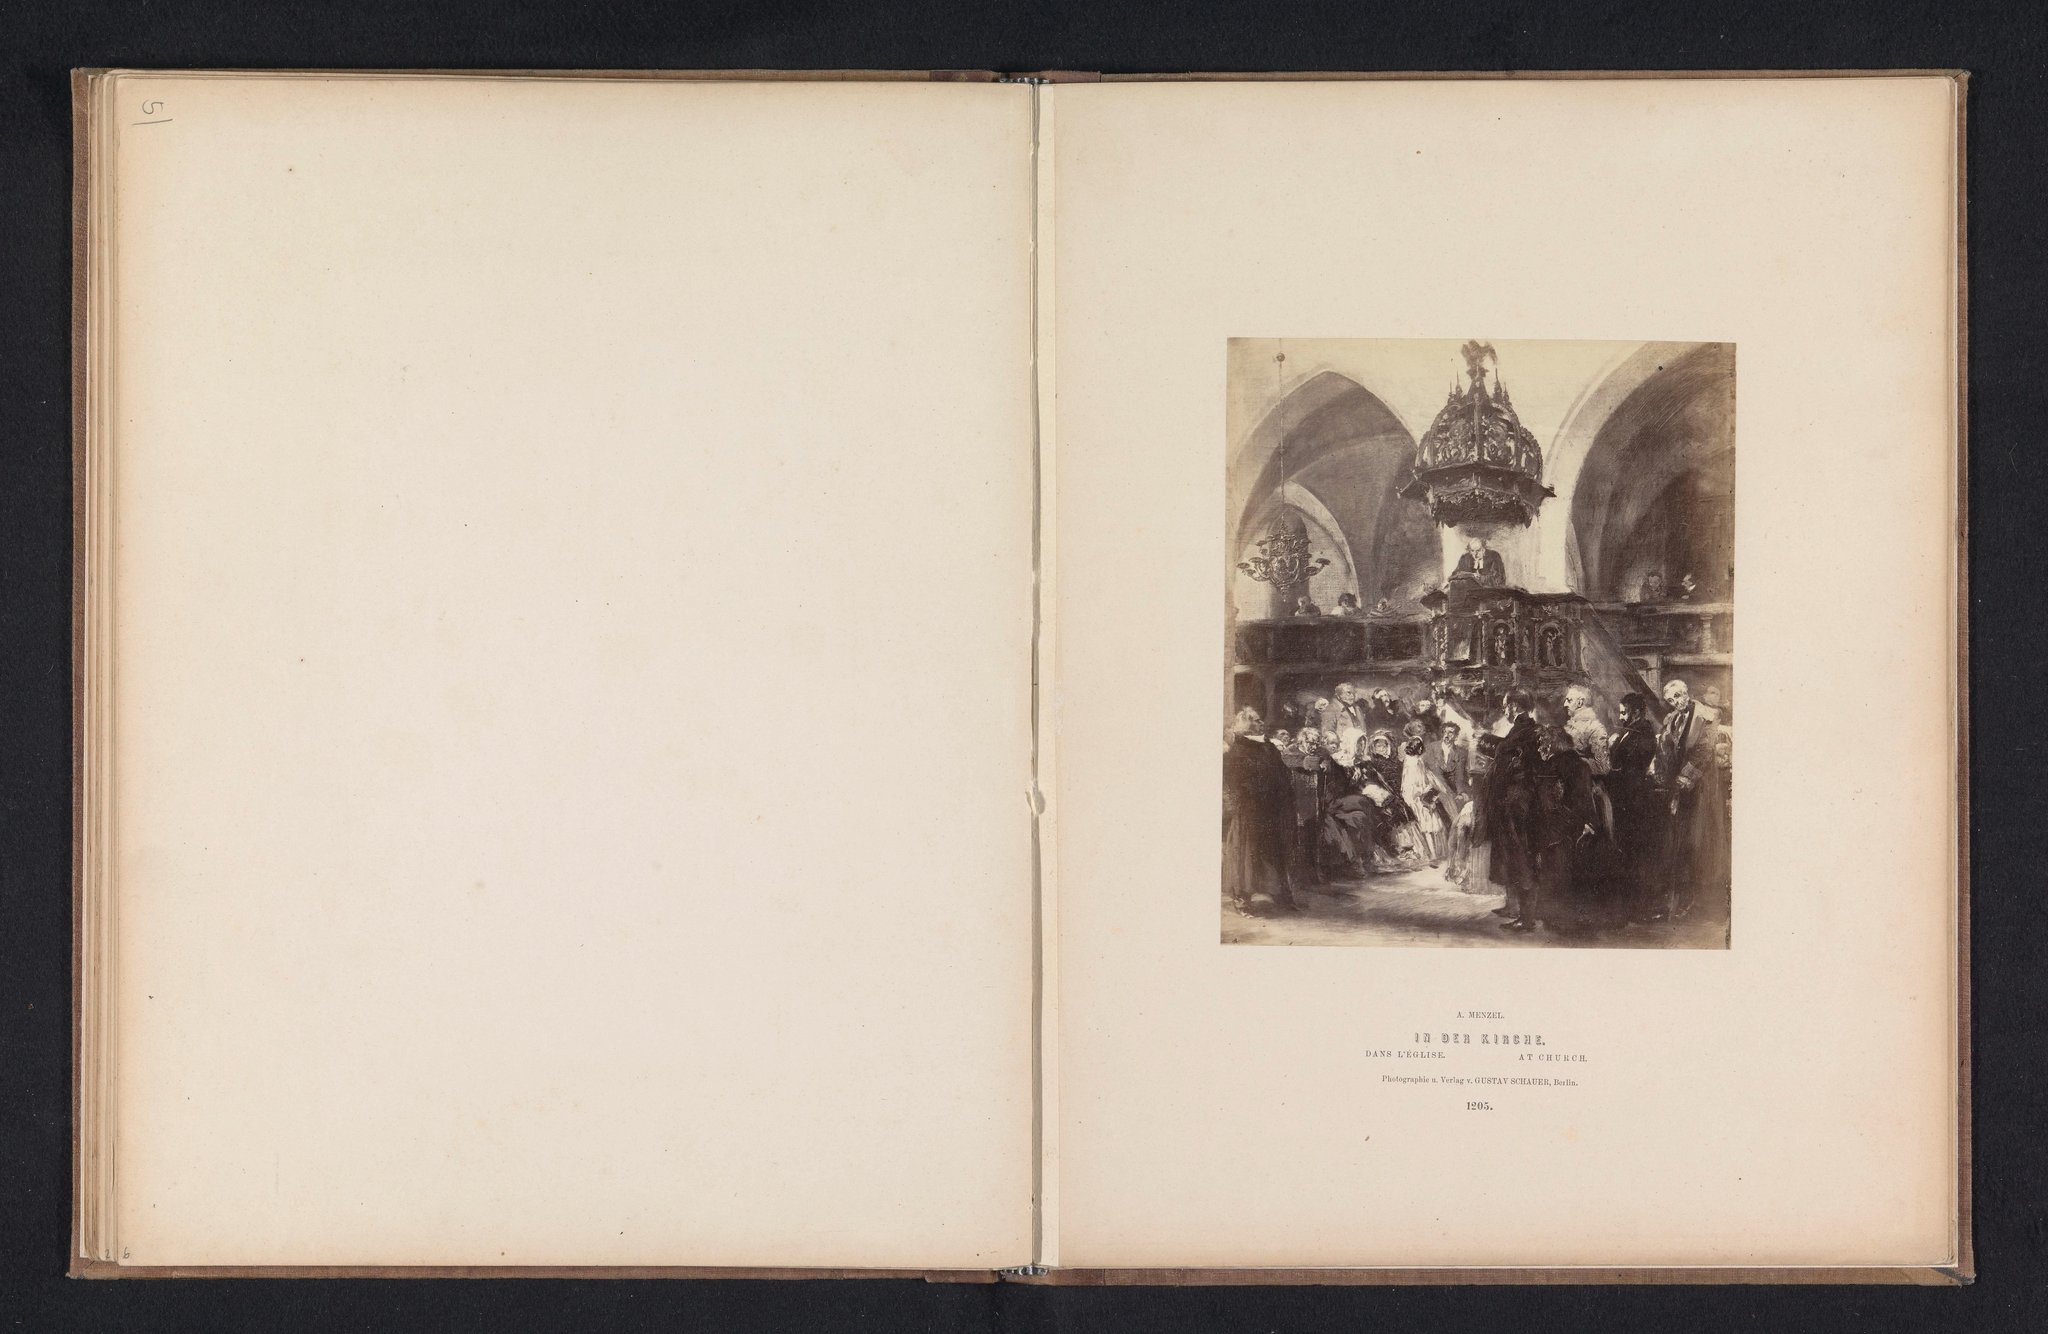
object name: photograph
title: Fotoreproductie van een schilderij van een kerkinterieur tijdens een dienst door Adolf Menzel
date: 1858-1868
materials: photographic support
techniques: albumen print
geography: berlin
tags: divine service ~ christian churches, interior of church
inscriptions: number: ‘1205.’